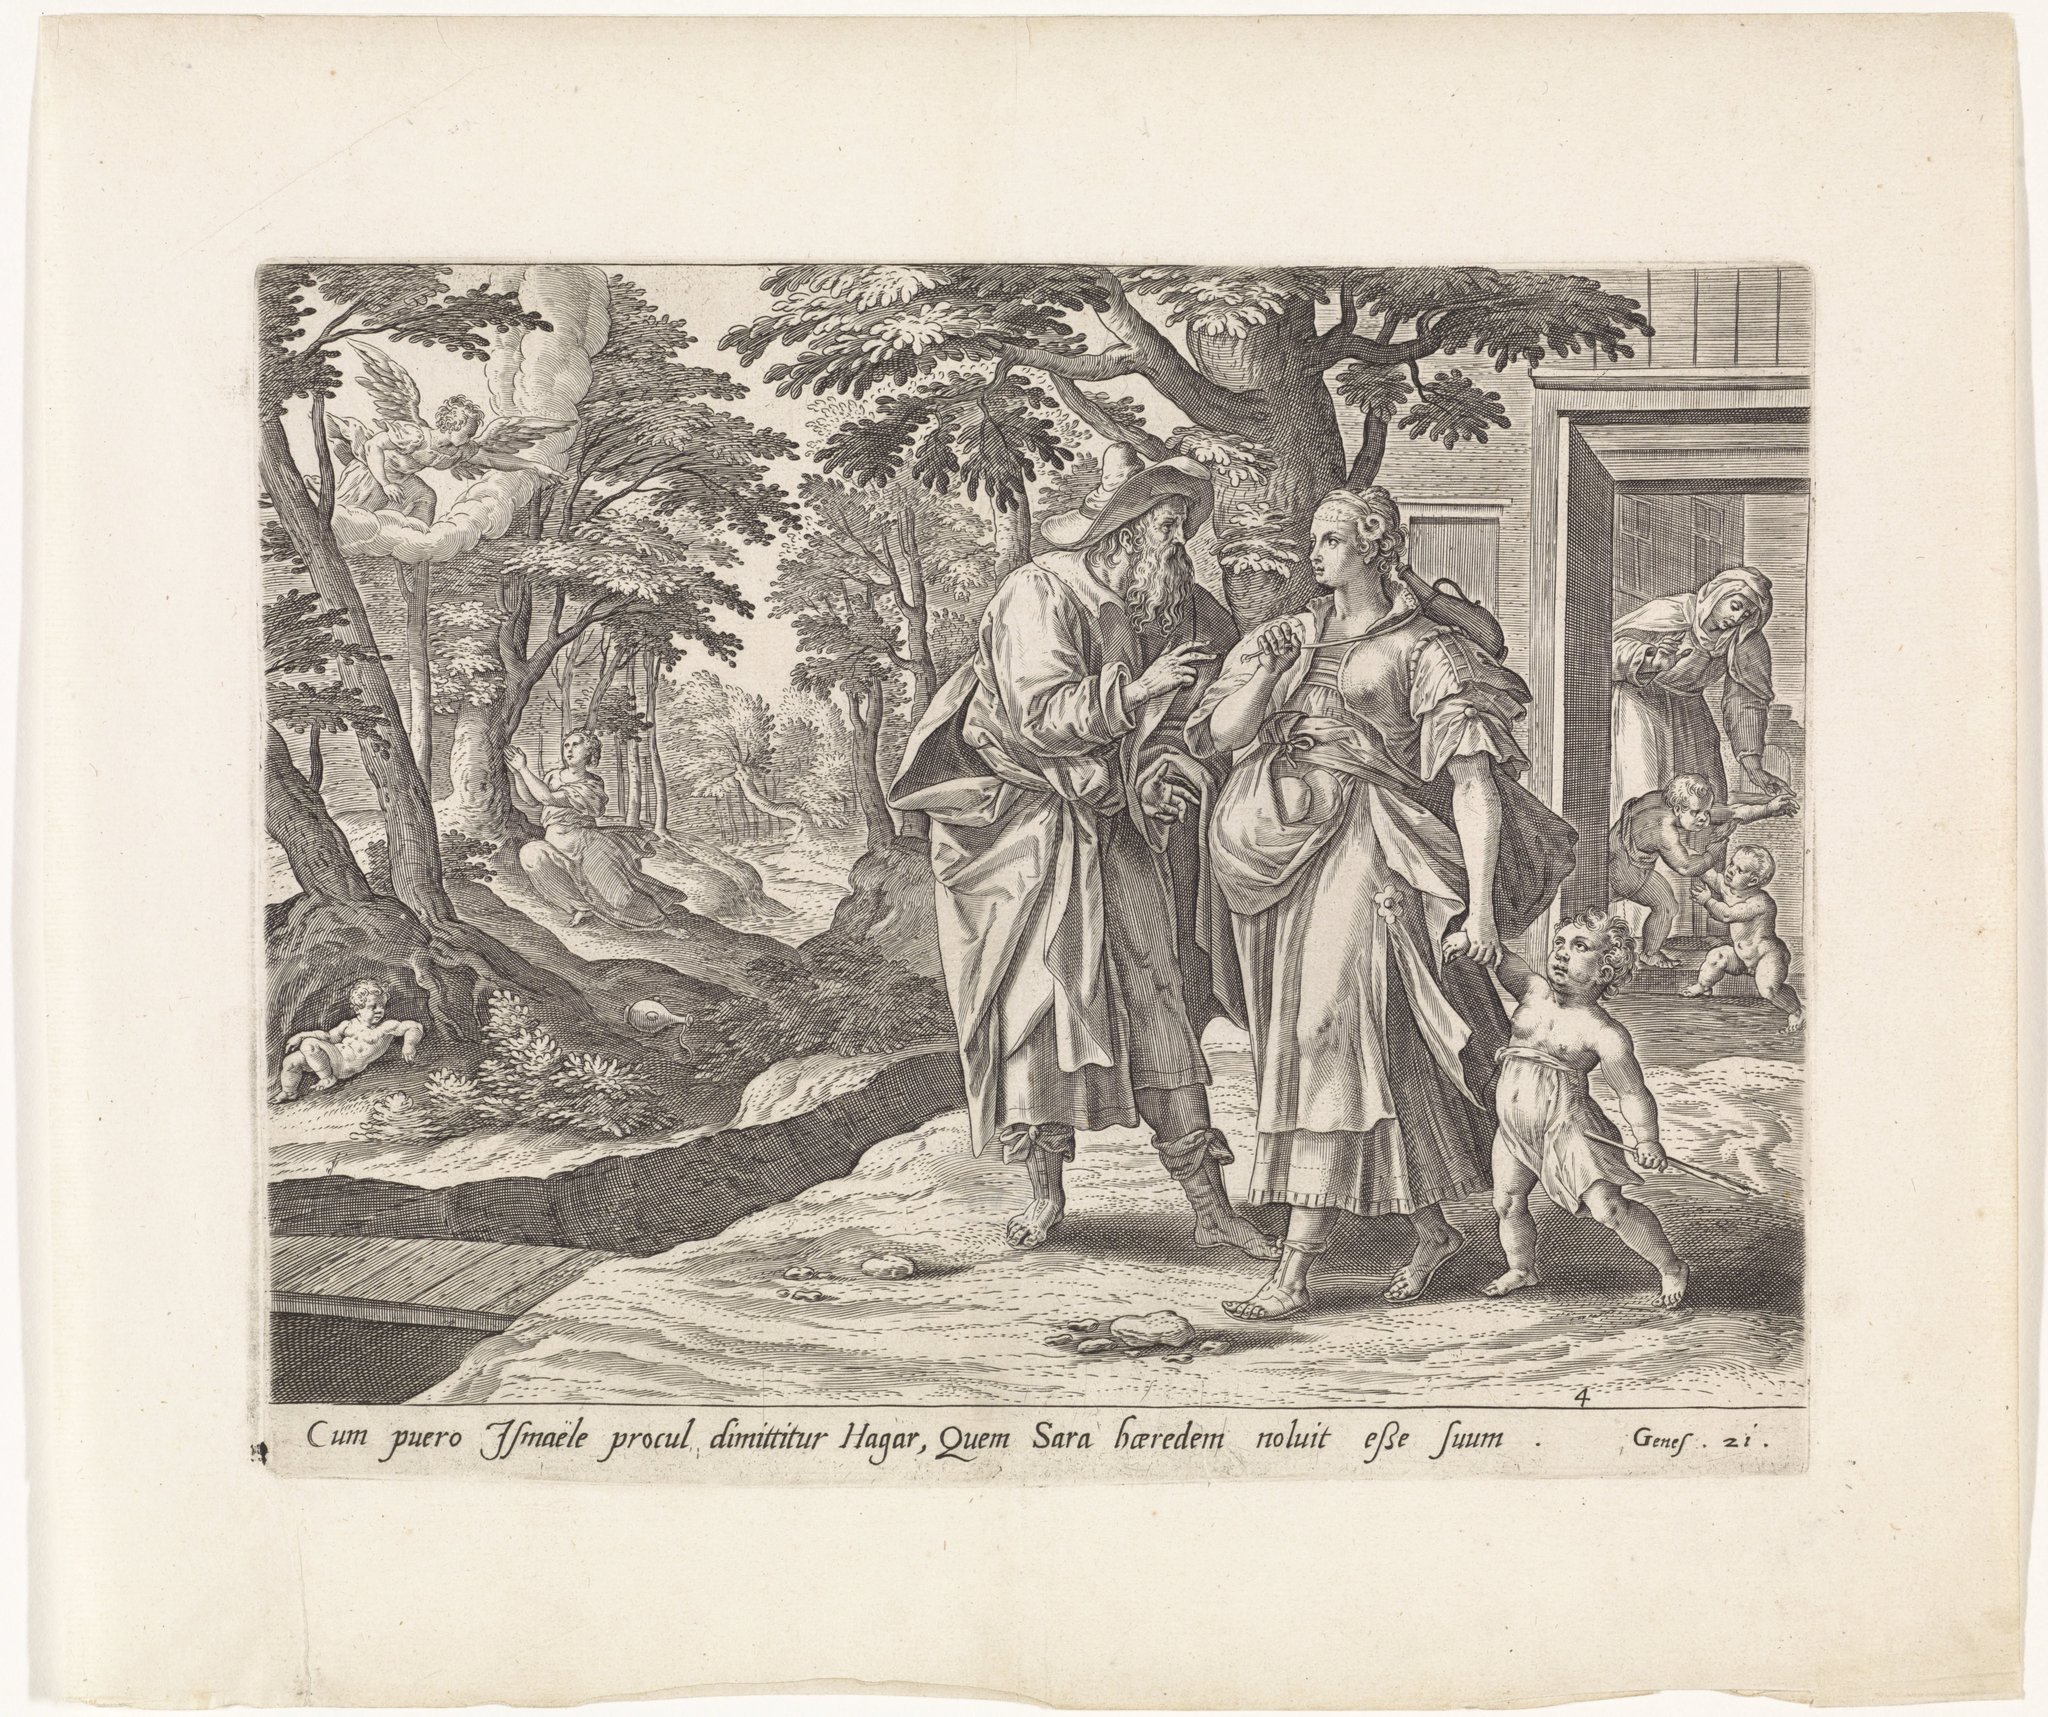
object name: print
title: Geschiedenis van Abraham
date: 1585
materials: paper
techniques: engraving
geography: antwerp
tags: abraham provides hagar and ishmael with bread and a jug of water, an angel appears and reveals a well of water to hagar, hagar sits weeping after having put ishmael under a bush to die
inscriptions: collector's mark: Lugt 2228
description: Abraham geeft Hagar en Ismaël broden en een kruik water mee en stuurt hen weg. Rechts op de achtergrond is de oorzaak van deze verstoting te zien: Ismaël bespot Isaäk. Daarom vroeg Sara aan Abraham om Hagar en Ismaël te verstoten. Links op de achtergrond Hagar en Ismaël in de wildernis. Ismaël ligt onder een boom, de lege kruikt op de grond. Een engel wijst de wanhopige Hagar op een bron. Onder de voorstelling een verwijzing in het Latijn naar de Bijbeltekst in Gen. 21.